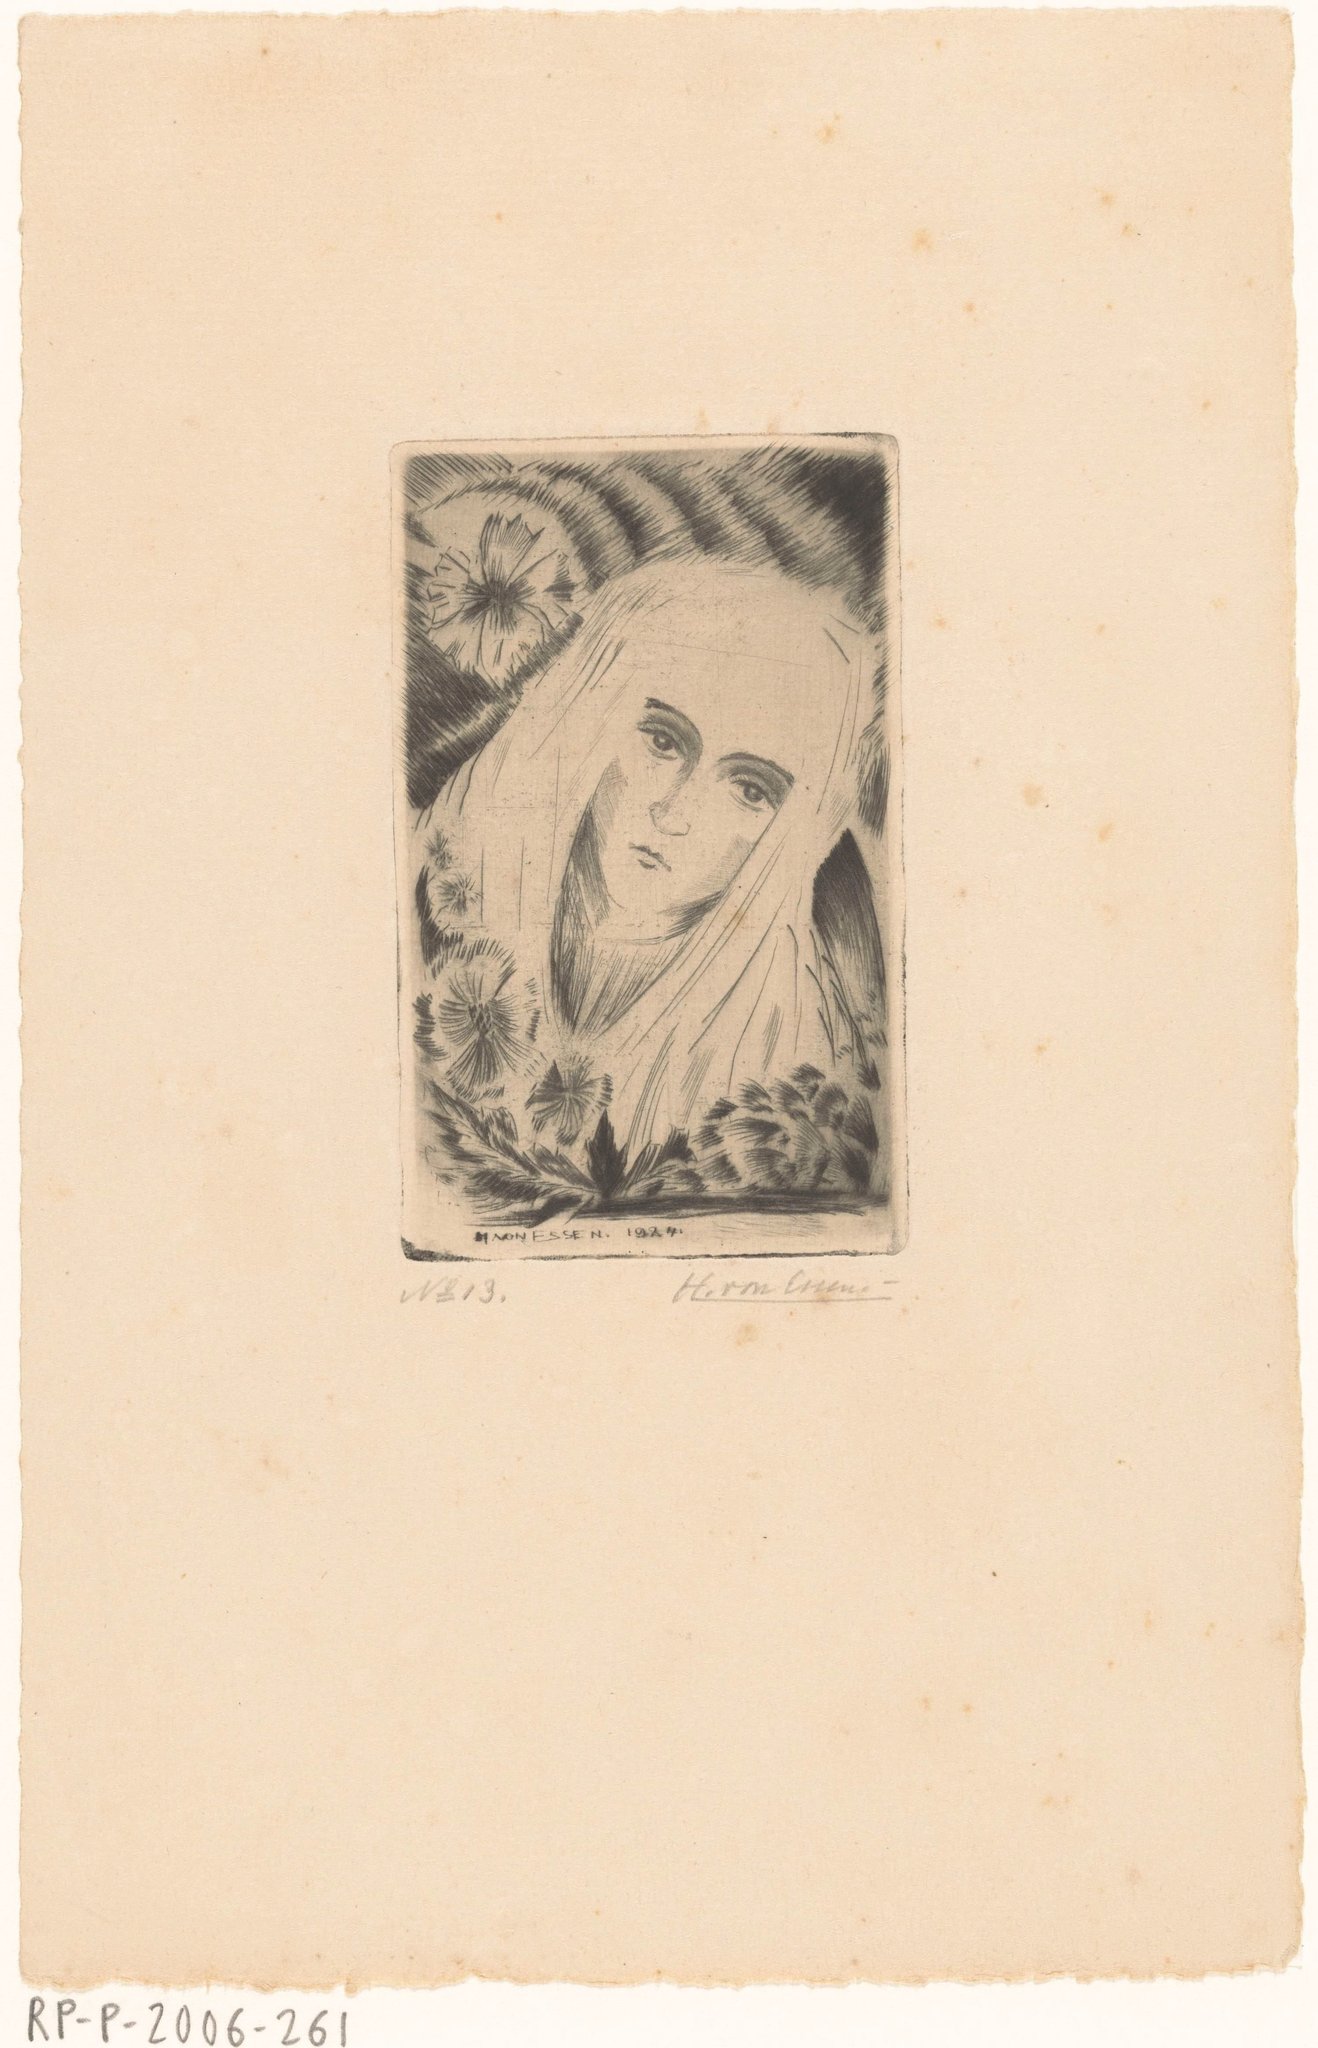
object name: print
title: Vrouw met hoofddoek te midden van bloemen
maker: hein von essen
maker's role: print maker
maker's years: 1886-1947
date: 1924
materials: paper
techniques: etching, soft ground etching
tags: flowers, head (human) - aa - female human figure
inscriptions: collector's mark: Lugt 2228